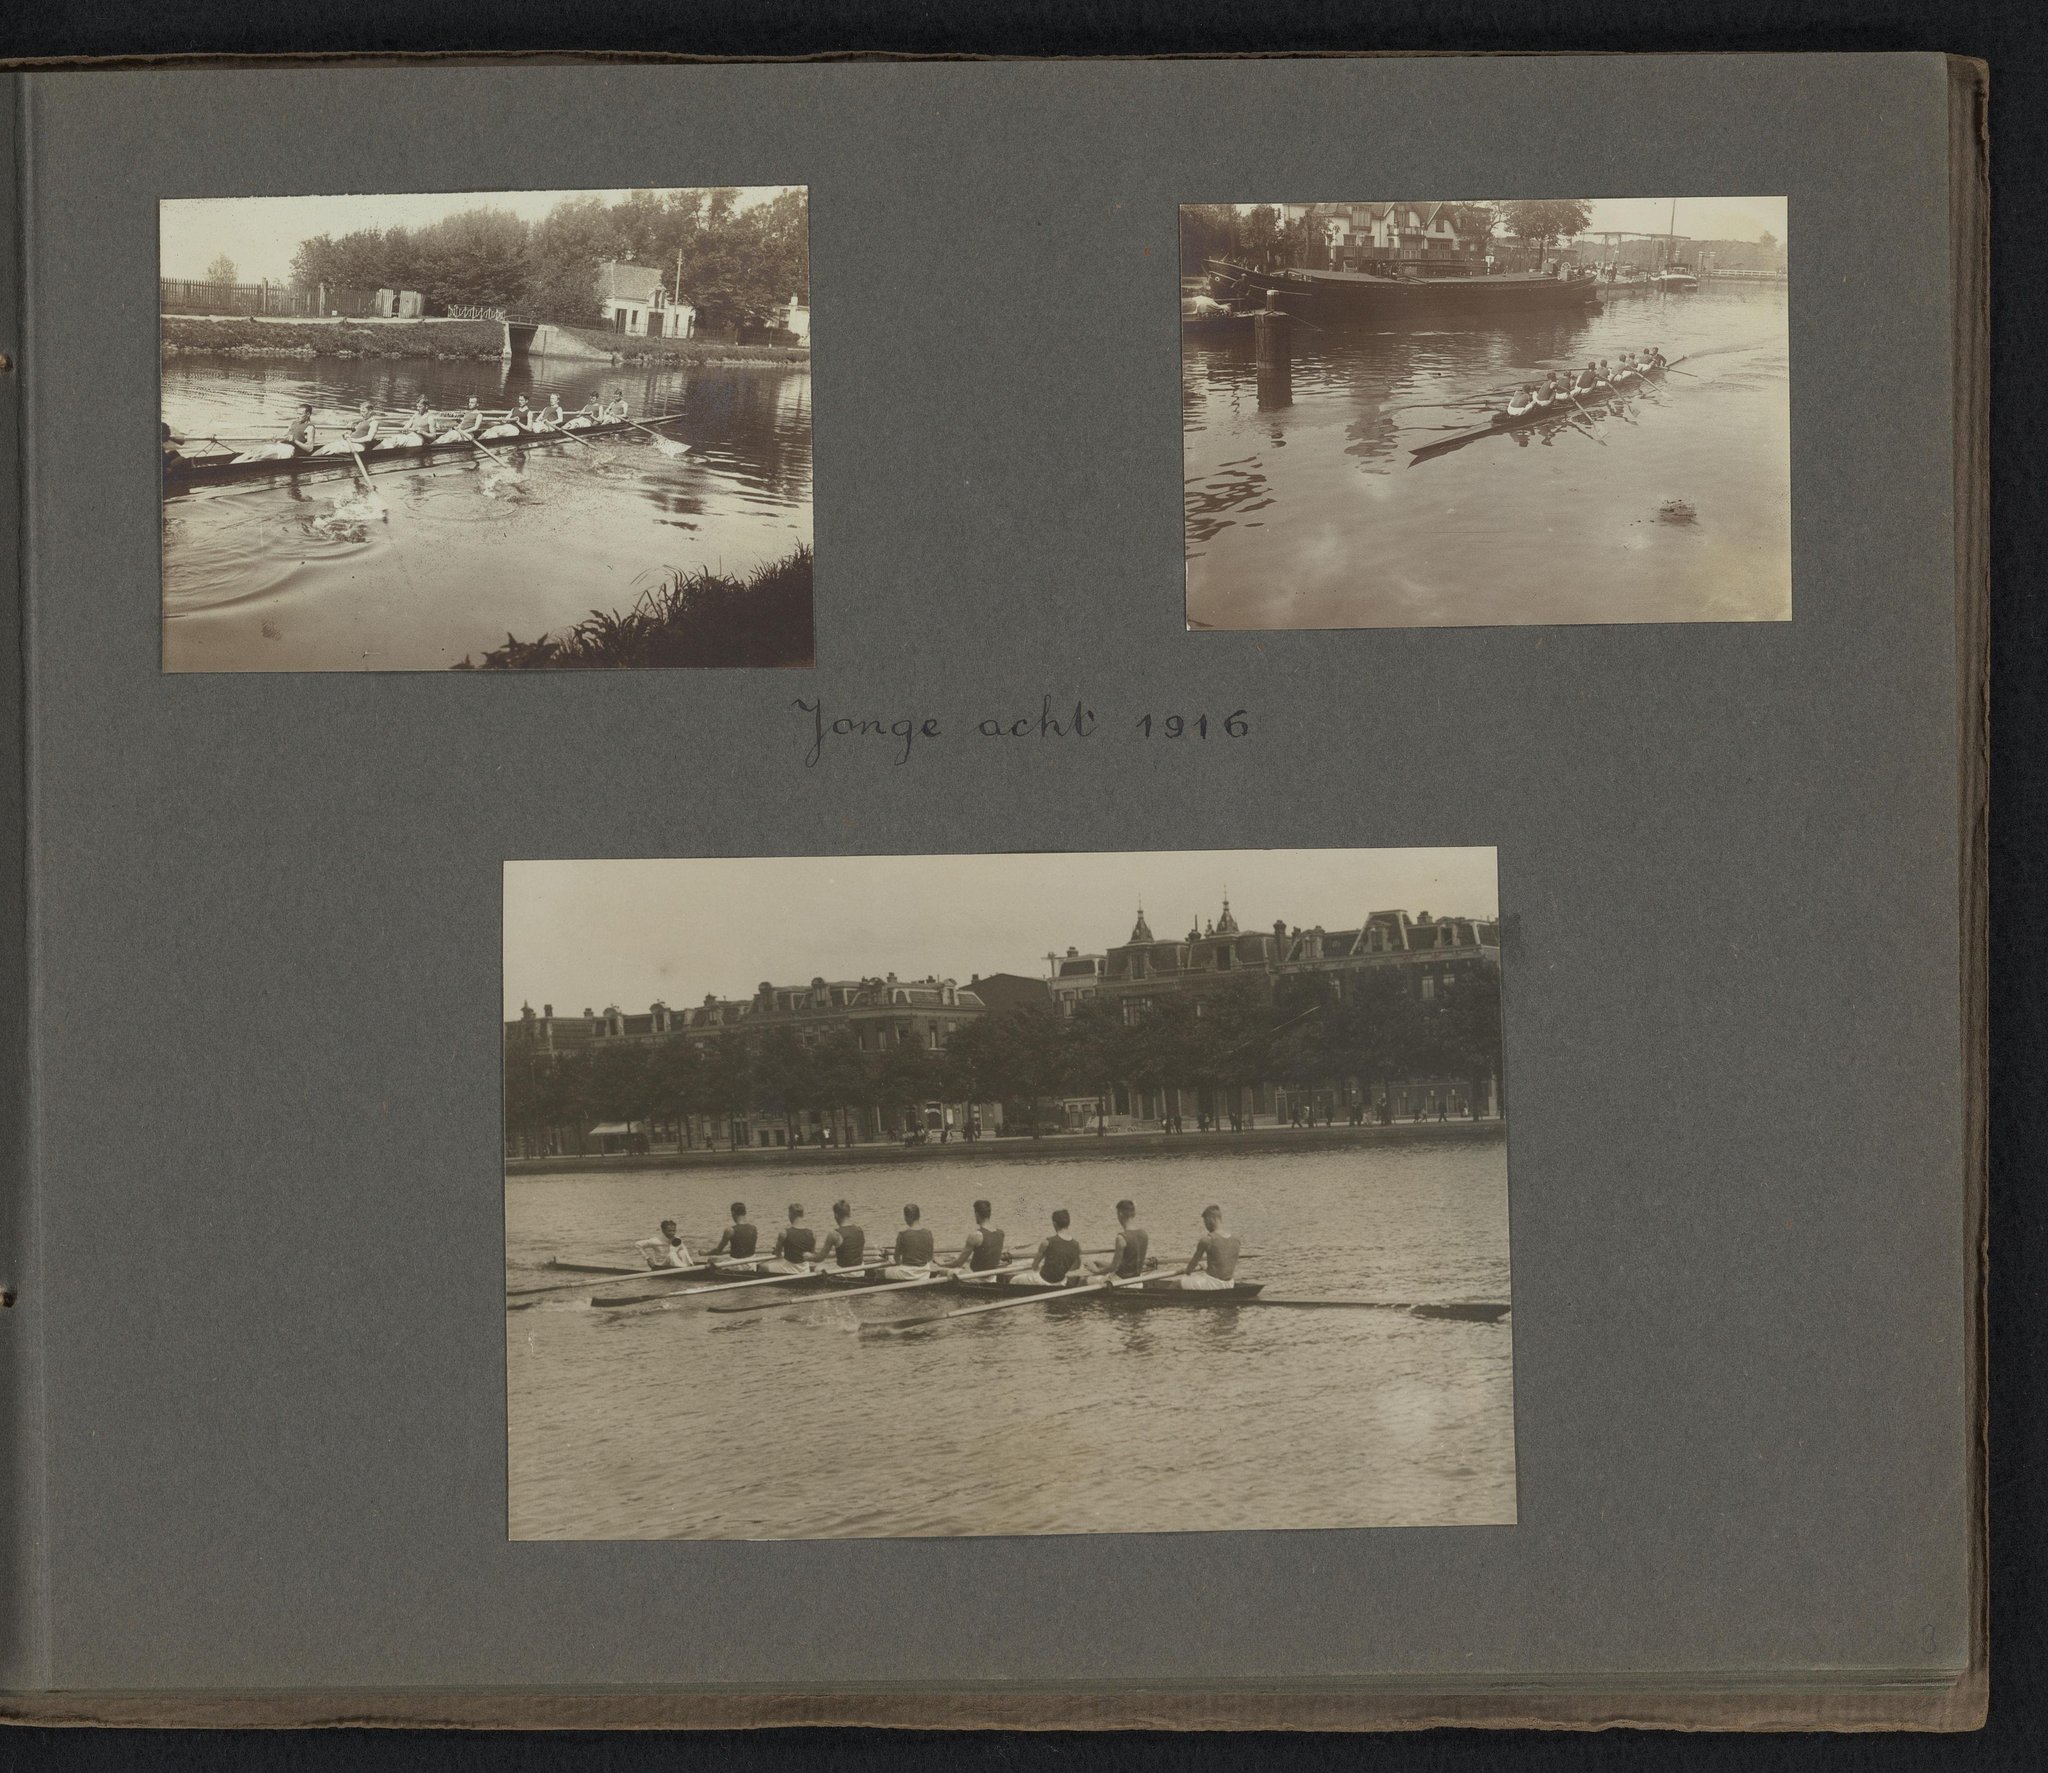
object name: album leaf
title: Drie foto's van Jonge Acht in actie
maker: Anonymous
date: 1916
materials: paper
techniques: gelatin silver print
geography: delft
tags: rowing facing backward, pulling, rowing, canoeing, etc. (sport)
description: Deze foto's maken deel uit van een album.